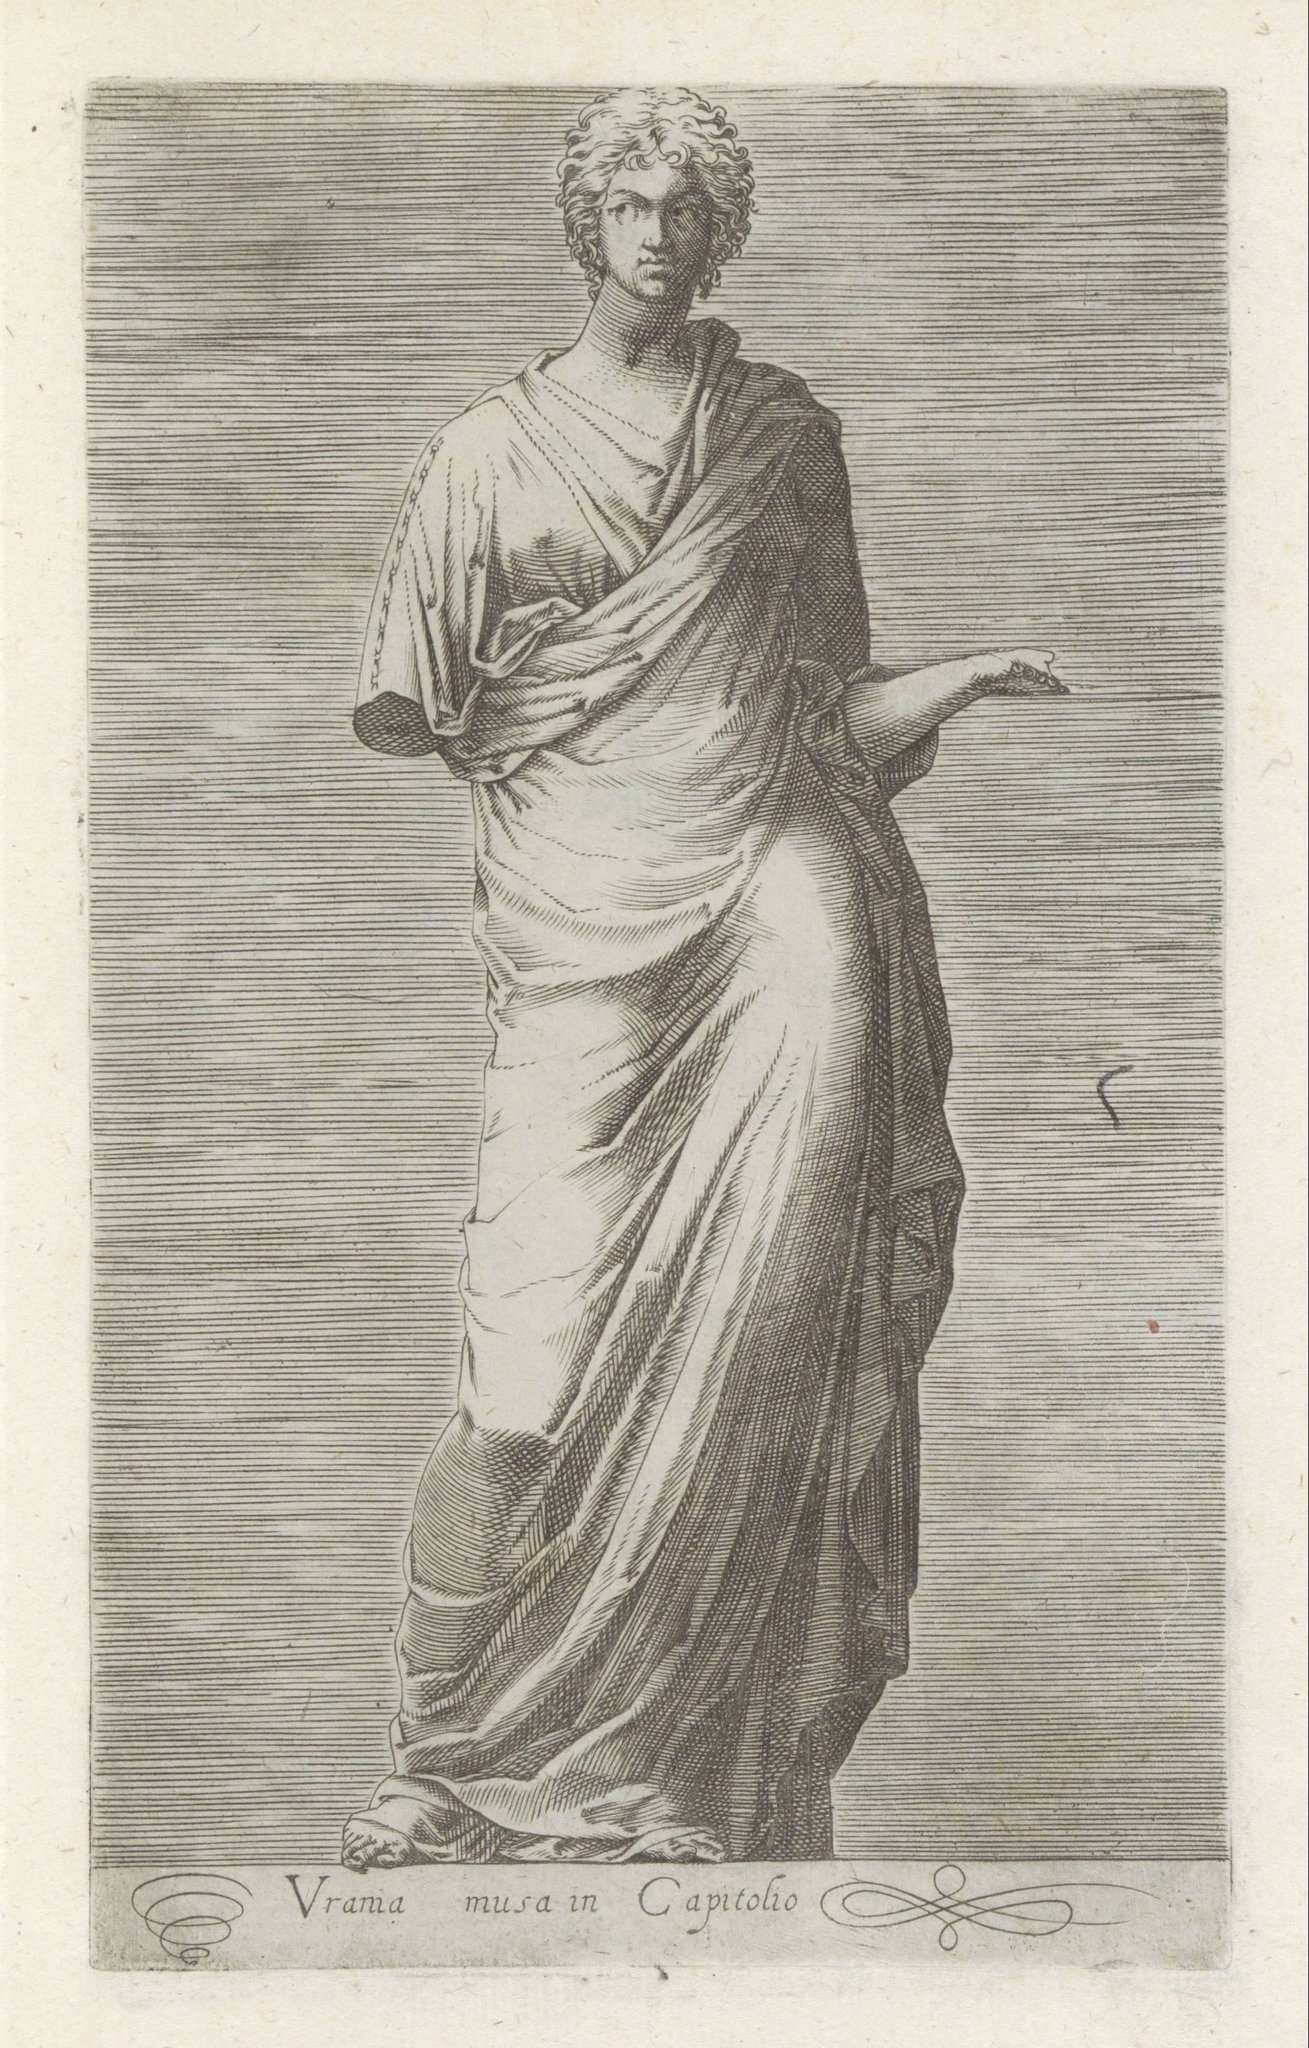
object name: print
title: Sculptuur van Urania, muze van de sterrenkunde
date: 1584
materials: paper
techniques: engraving, intaglio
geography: rome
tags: piece of sculpture, reproduction of a piece of sculpture, urania (one of the muses); 'urania' (ripa)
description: Deze prent maakt deel uit van een set van 79 prenten (+ titelprent) met voorstellingen van antieke sculpturen in Rome.